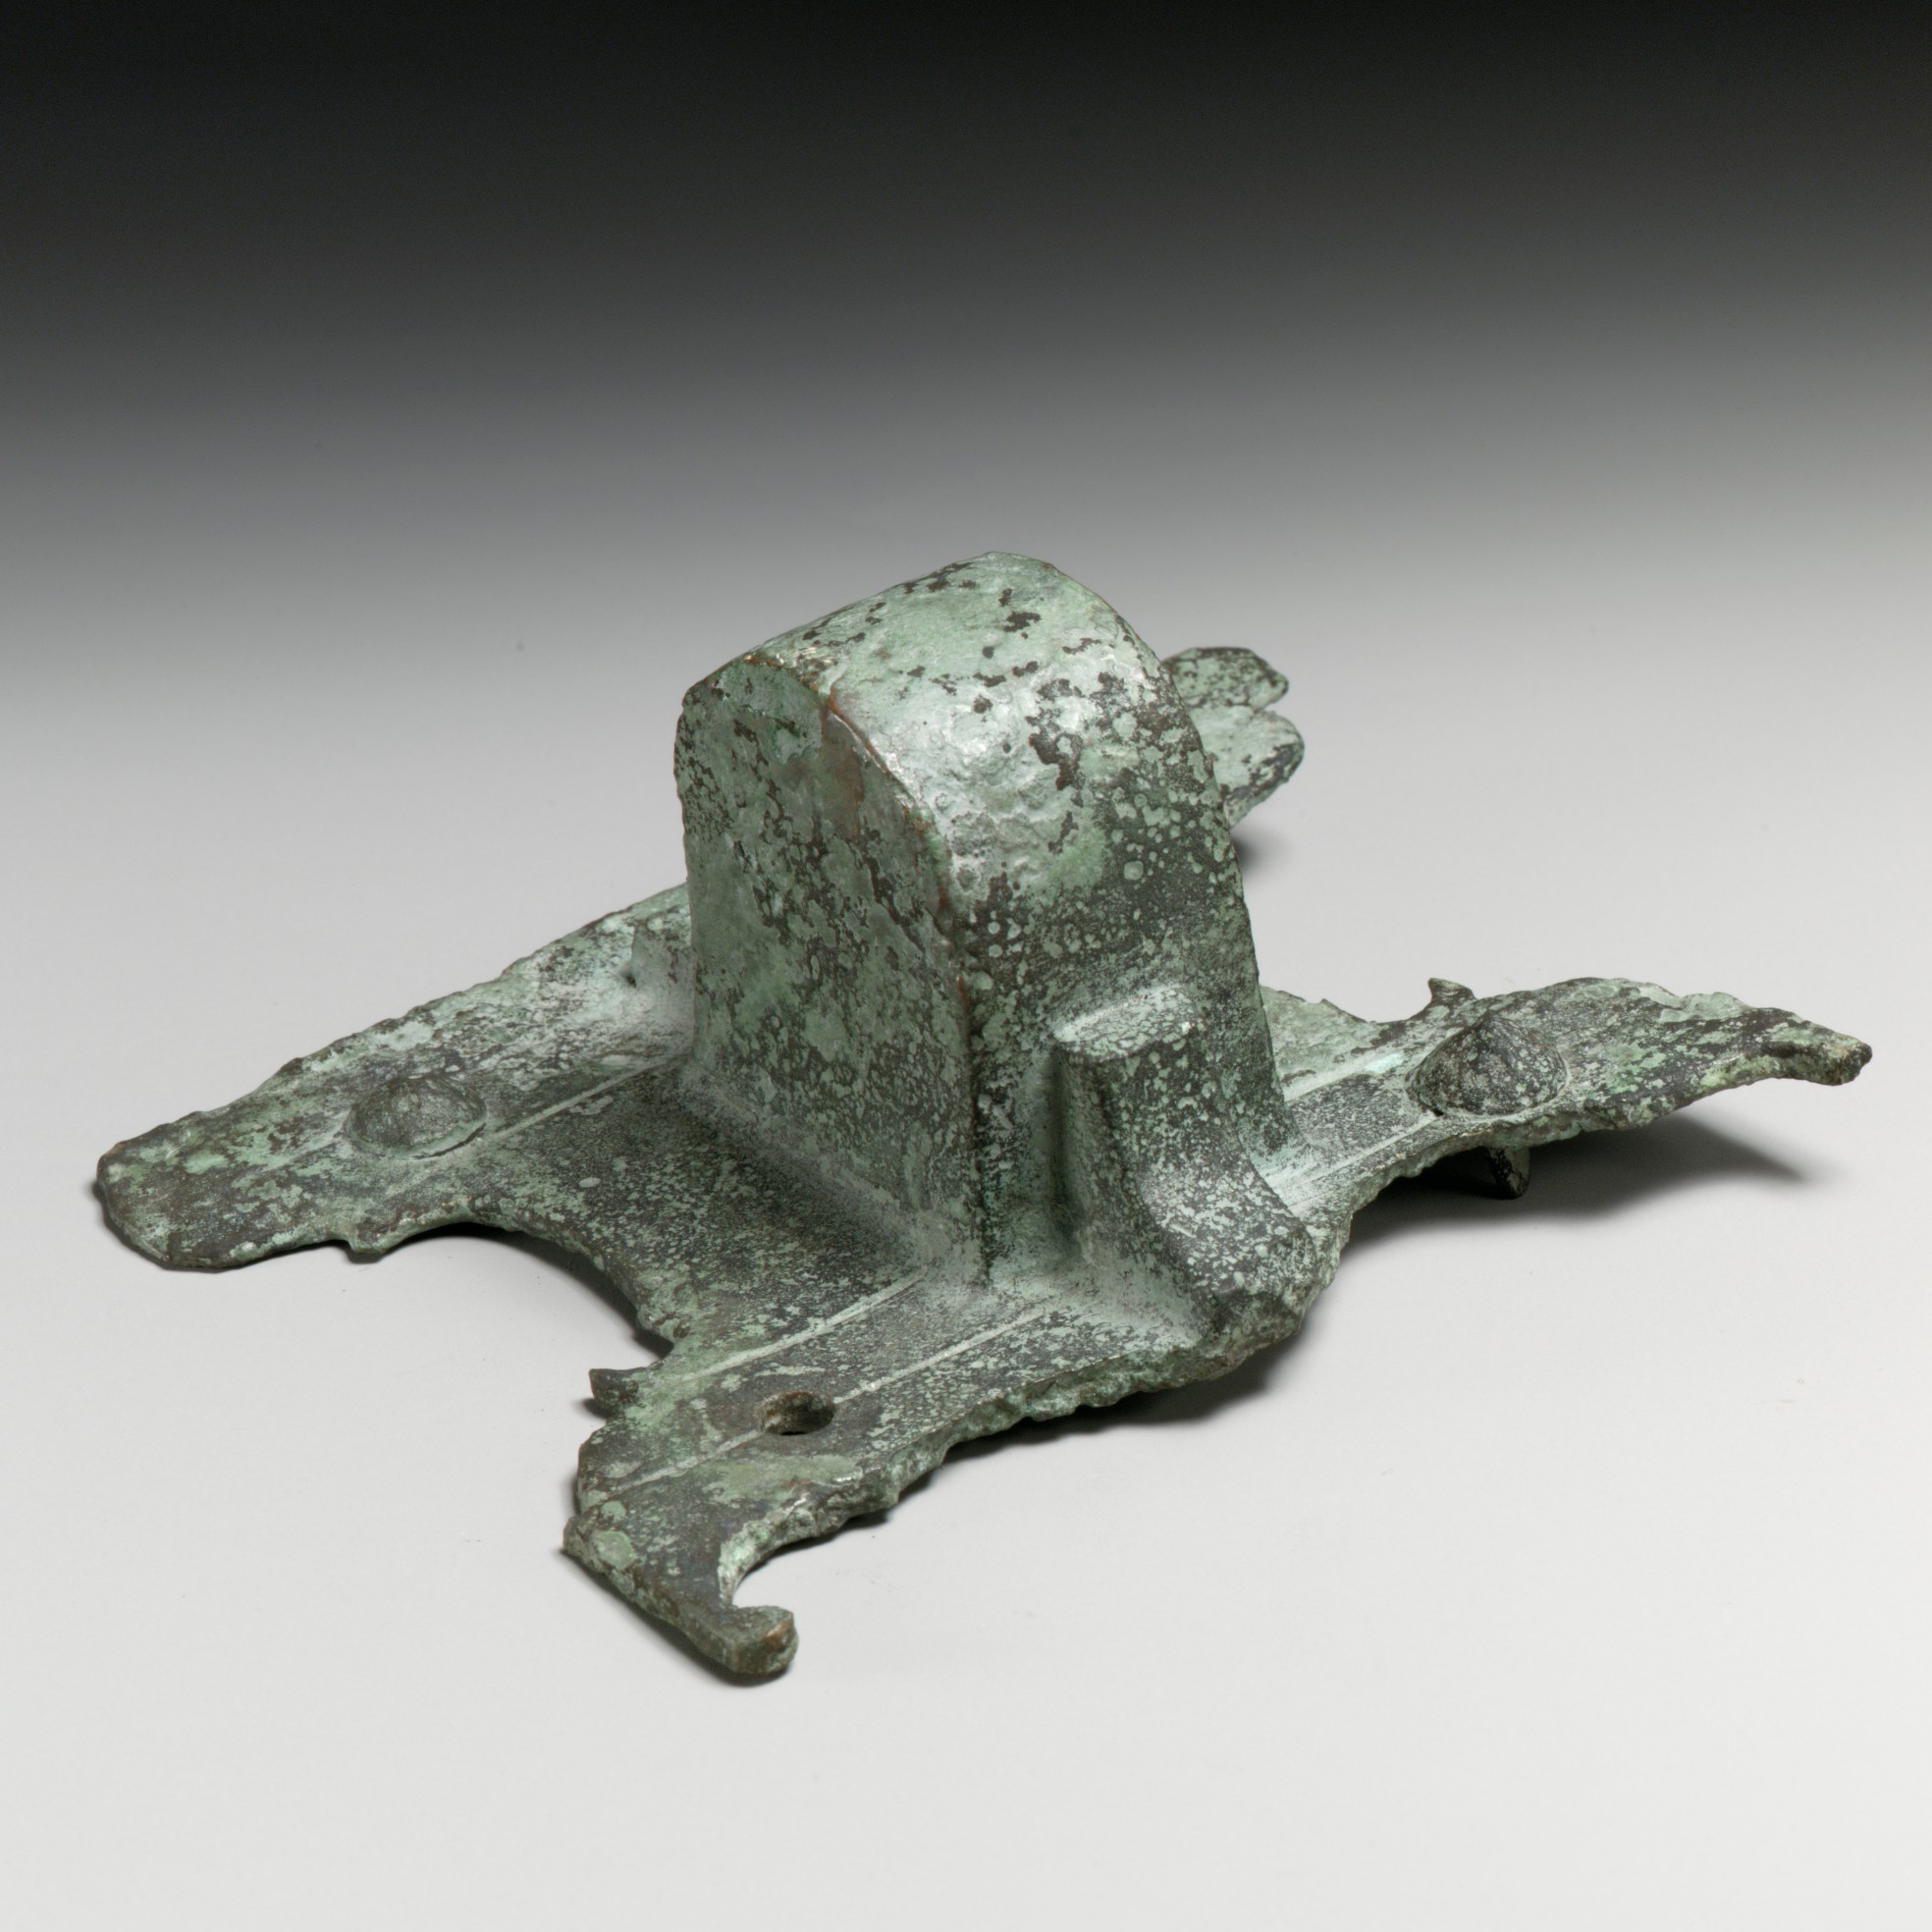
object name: chariot fragment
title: Fragment of a cart or chariot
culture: etruscan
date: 500-480 BCE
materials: bronze